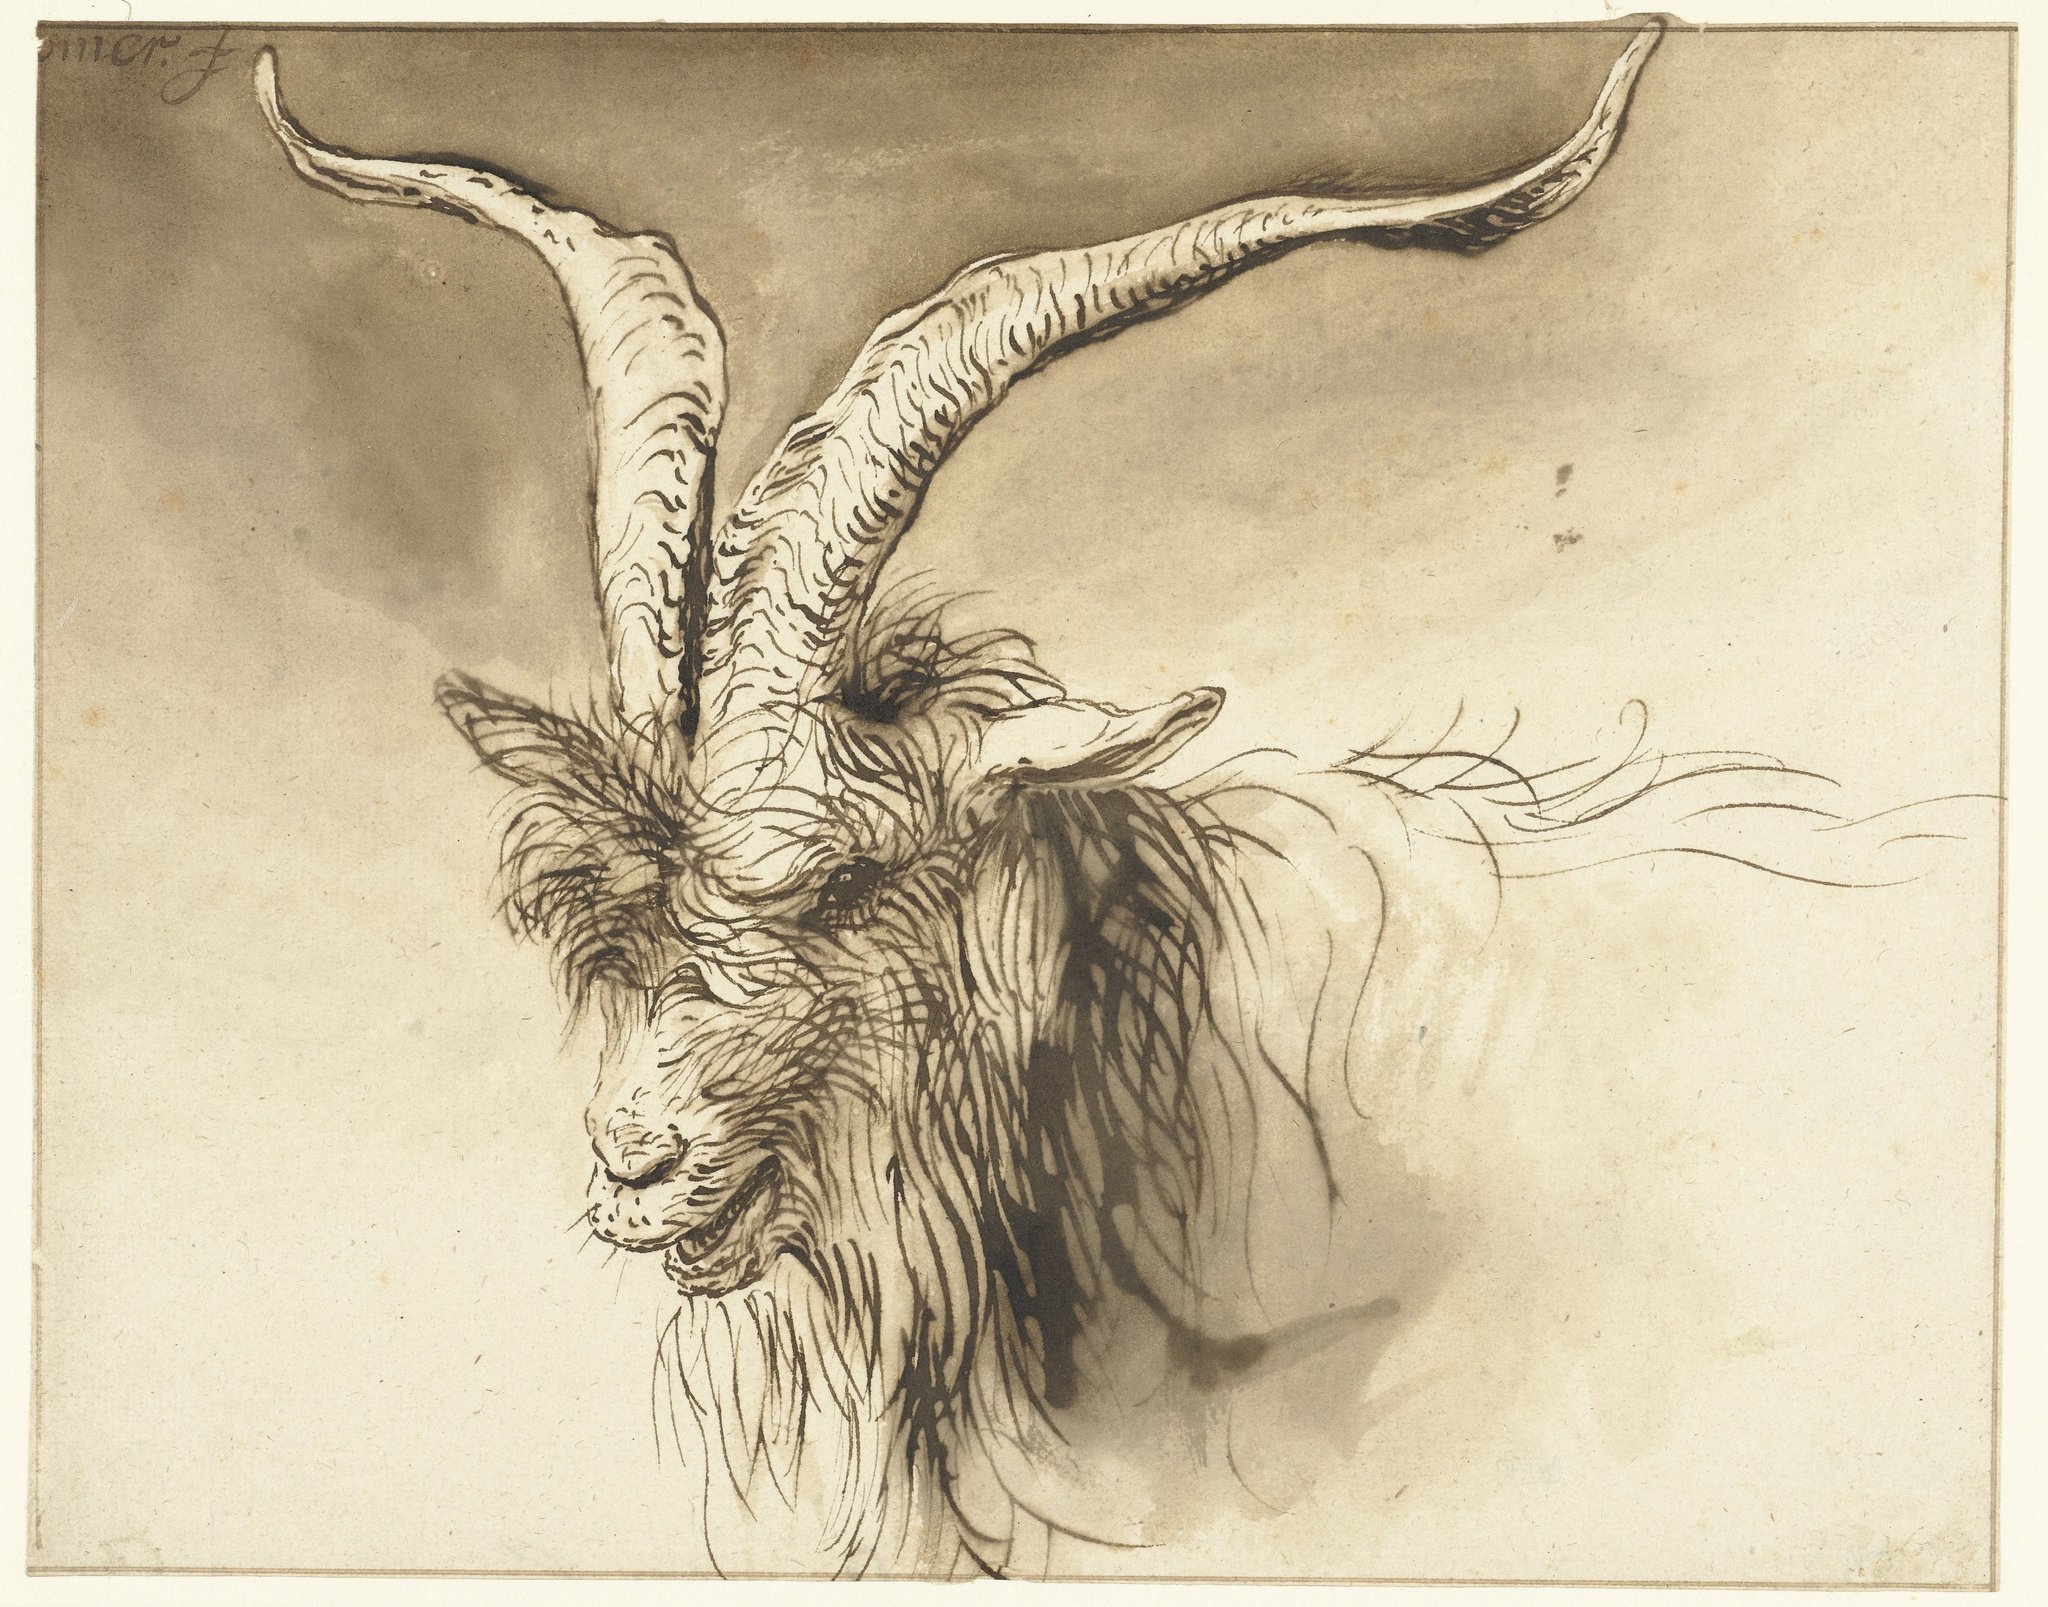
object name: drawing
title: Head of a Dutch Landrace Goat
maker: lambert doomer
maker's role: draughtsman, painter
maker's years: 1622-1700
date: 1655-1665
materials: ink, paper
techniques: brush, pen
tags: hoofed animals: ibex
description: Lambert Doomer drew the head of this buck, recognizable from the tuft of hair on its chin and characteristic ribbed horns, with loose, fanciful pen lines. The horns – curving back and with slightly turned up tips – can grow up to a metre long. The Amsterdam artist made various sketches of this animal, which then served as models for the goats in his paintings.